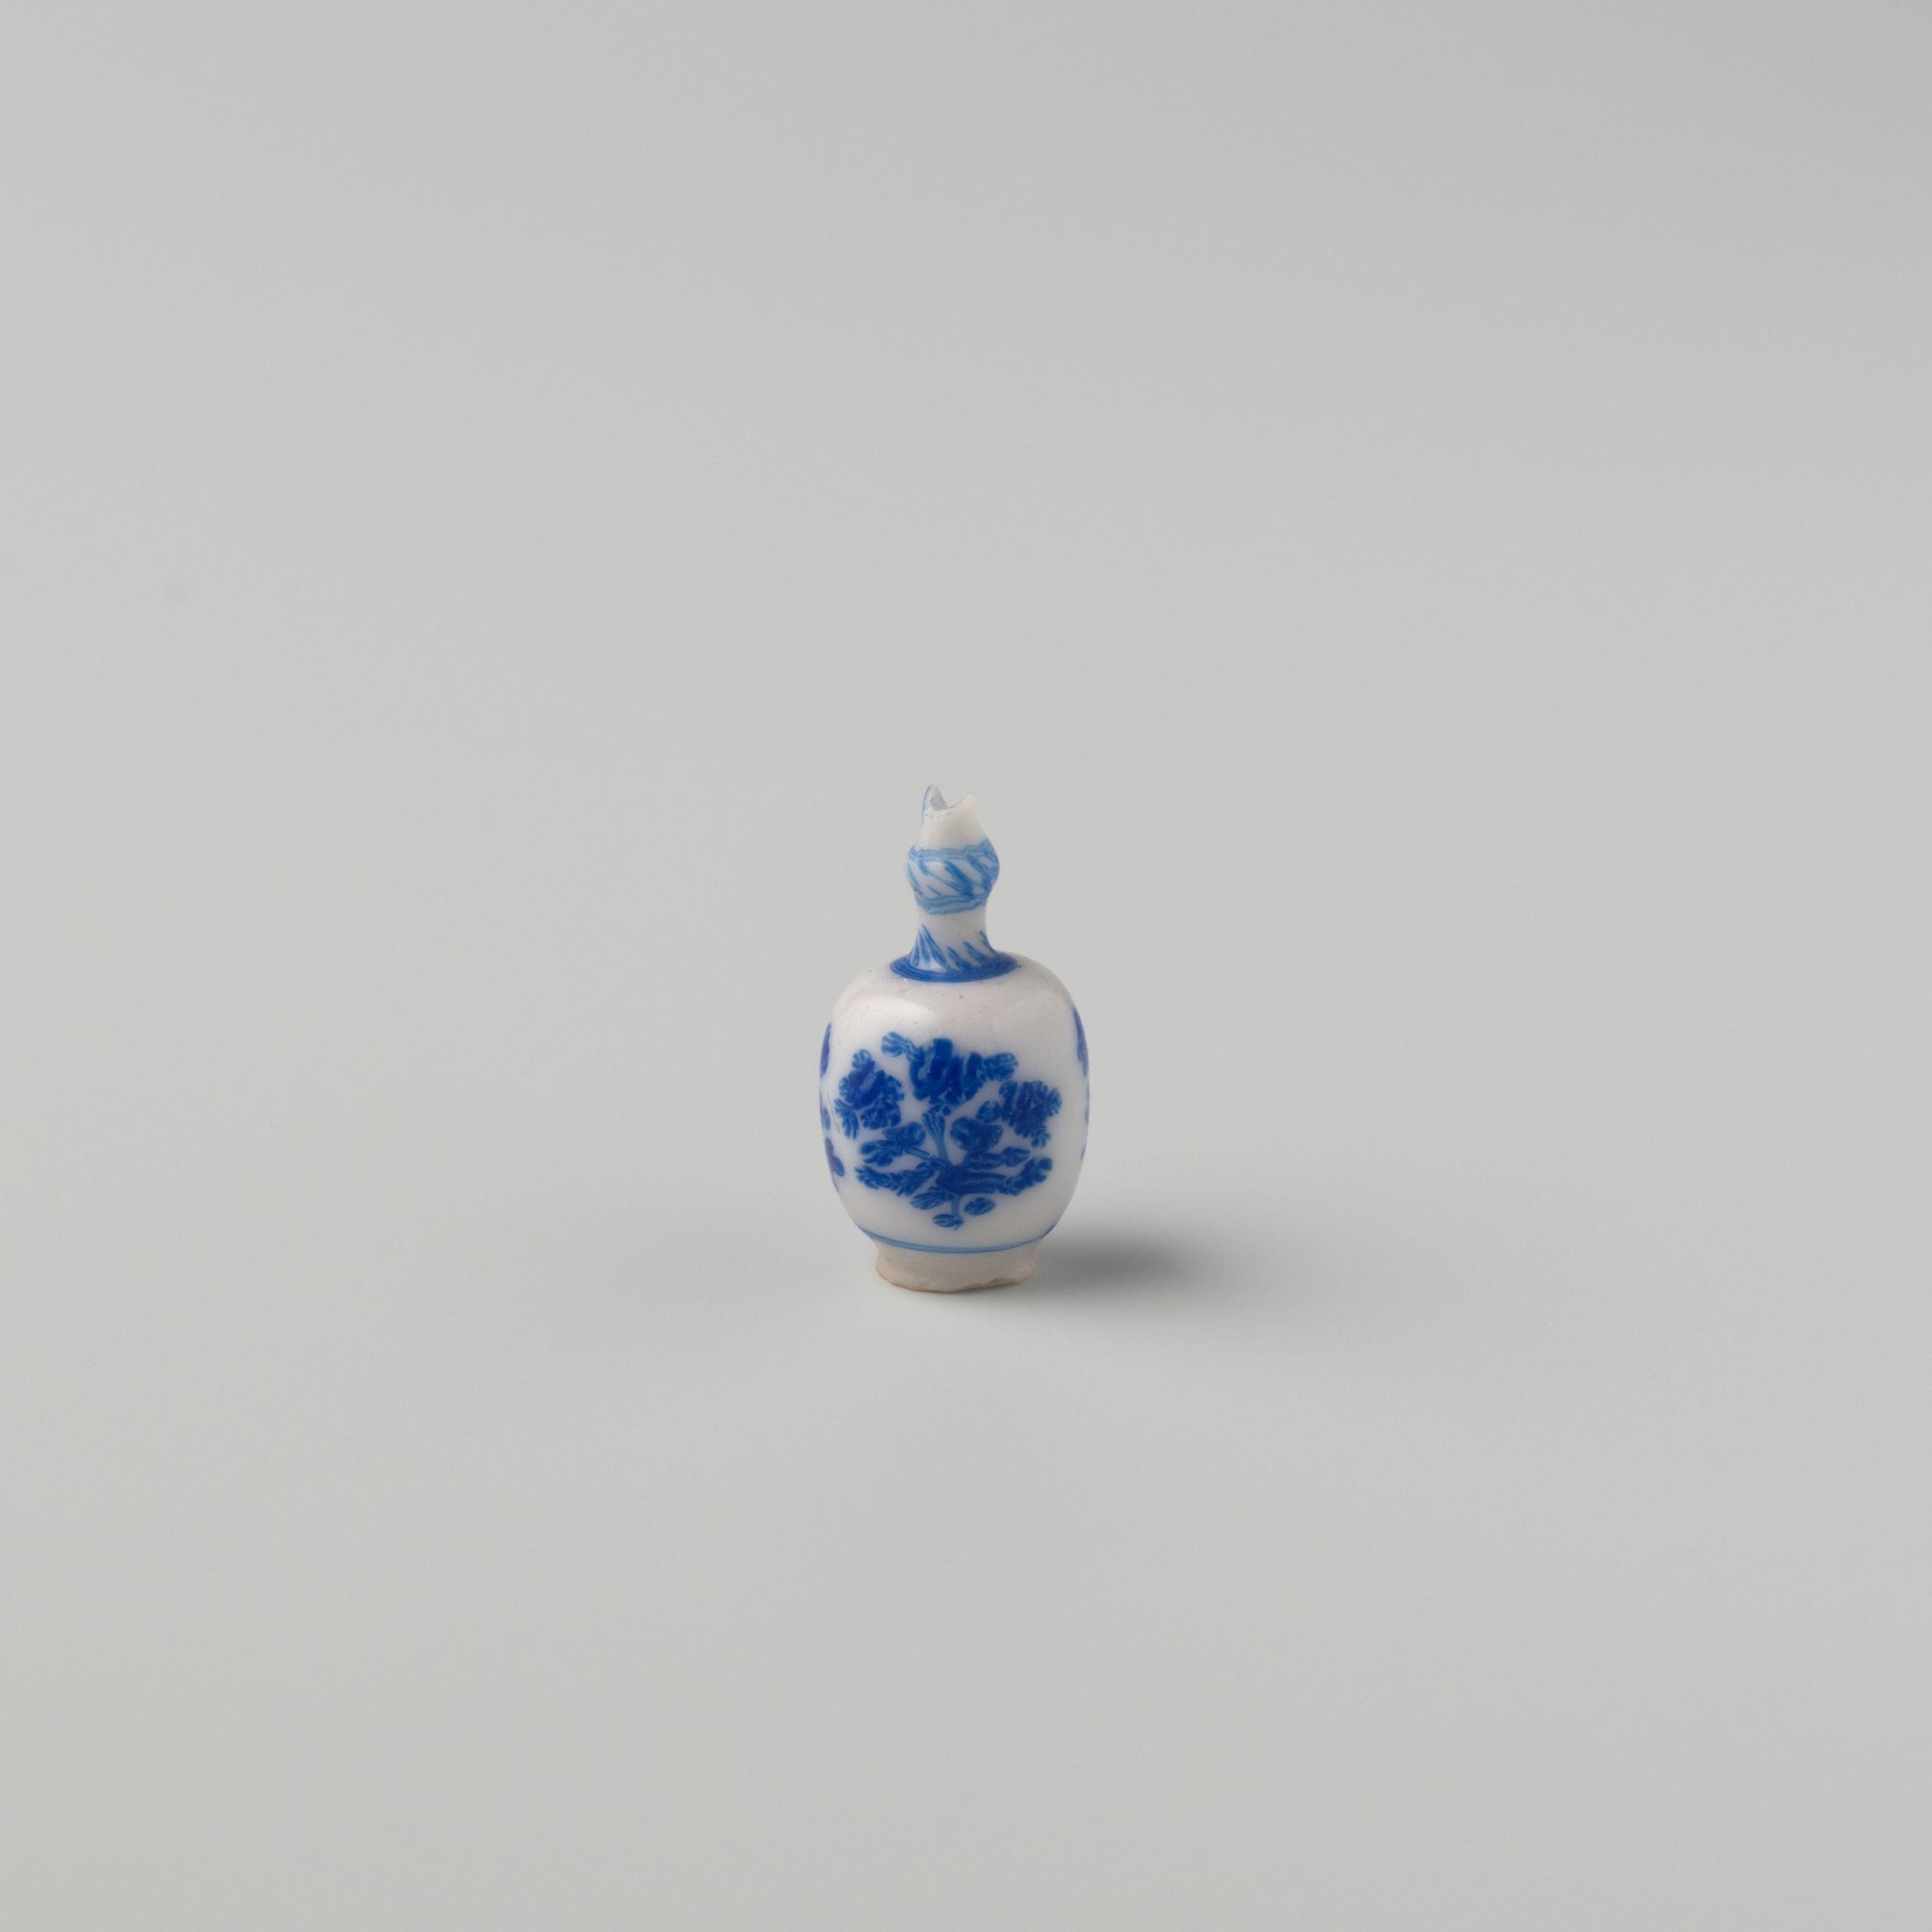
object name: bottle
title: Fles van melkglas met blauwe emailverf beschildering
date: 1675-1700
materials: glass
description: Fles van melkglas met blauwe emailverf beschildering, imitatie Chinees blauw porselein; model met afgeplakt, bolvormige buik waarop twee bloemtuilen en slanke hals met verdikking, versierd met streepjes. Op standring.